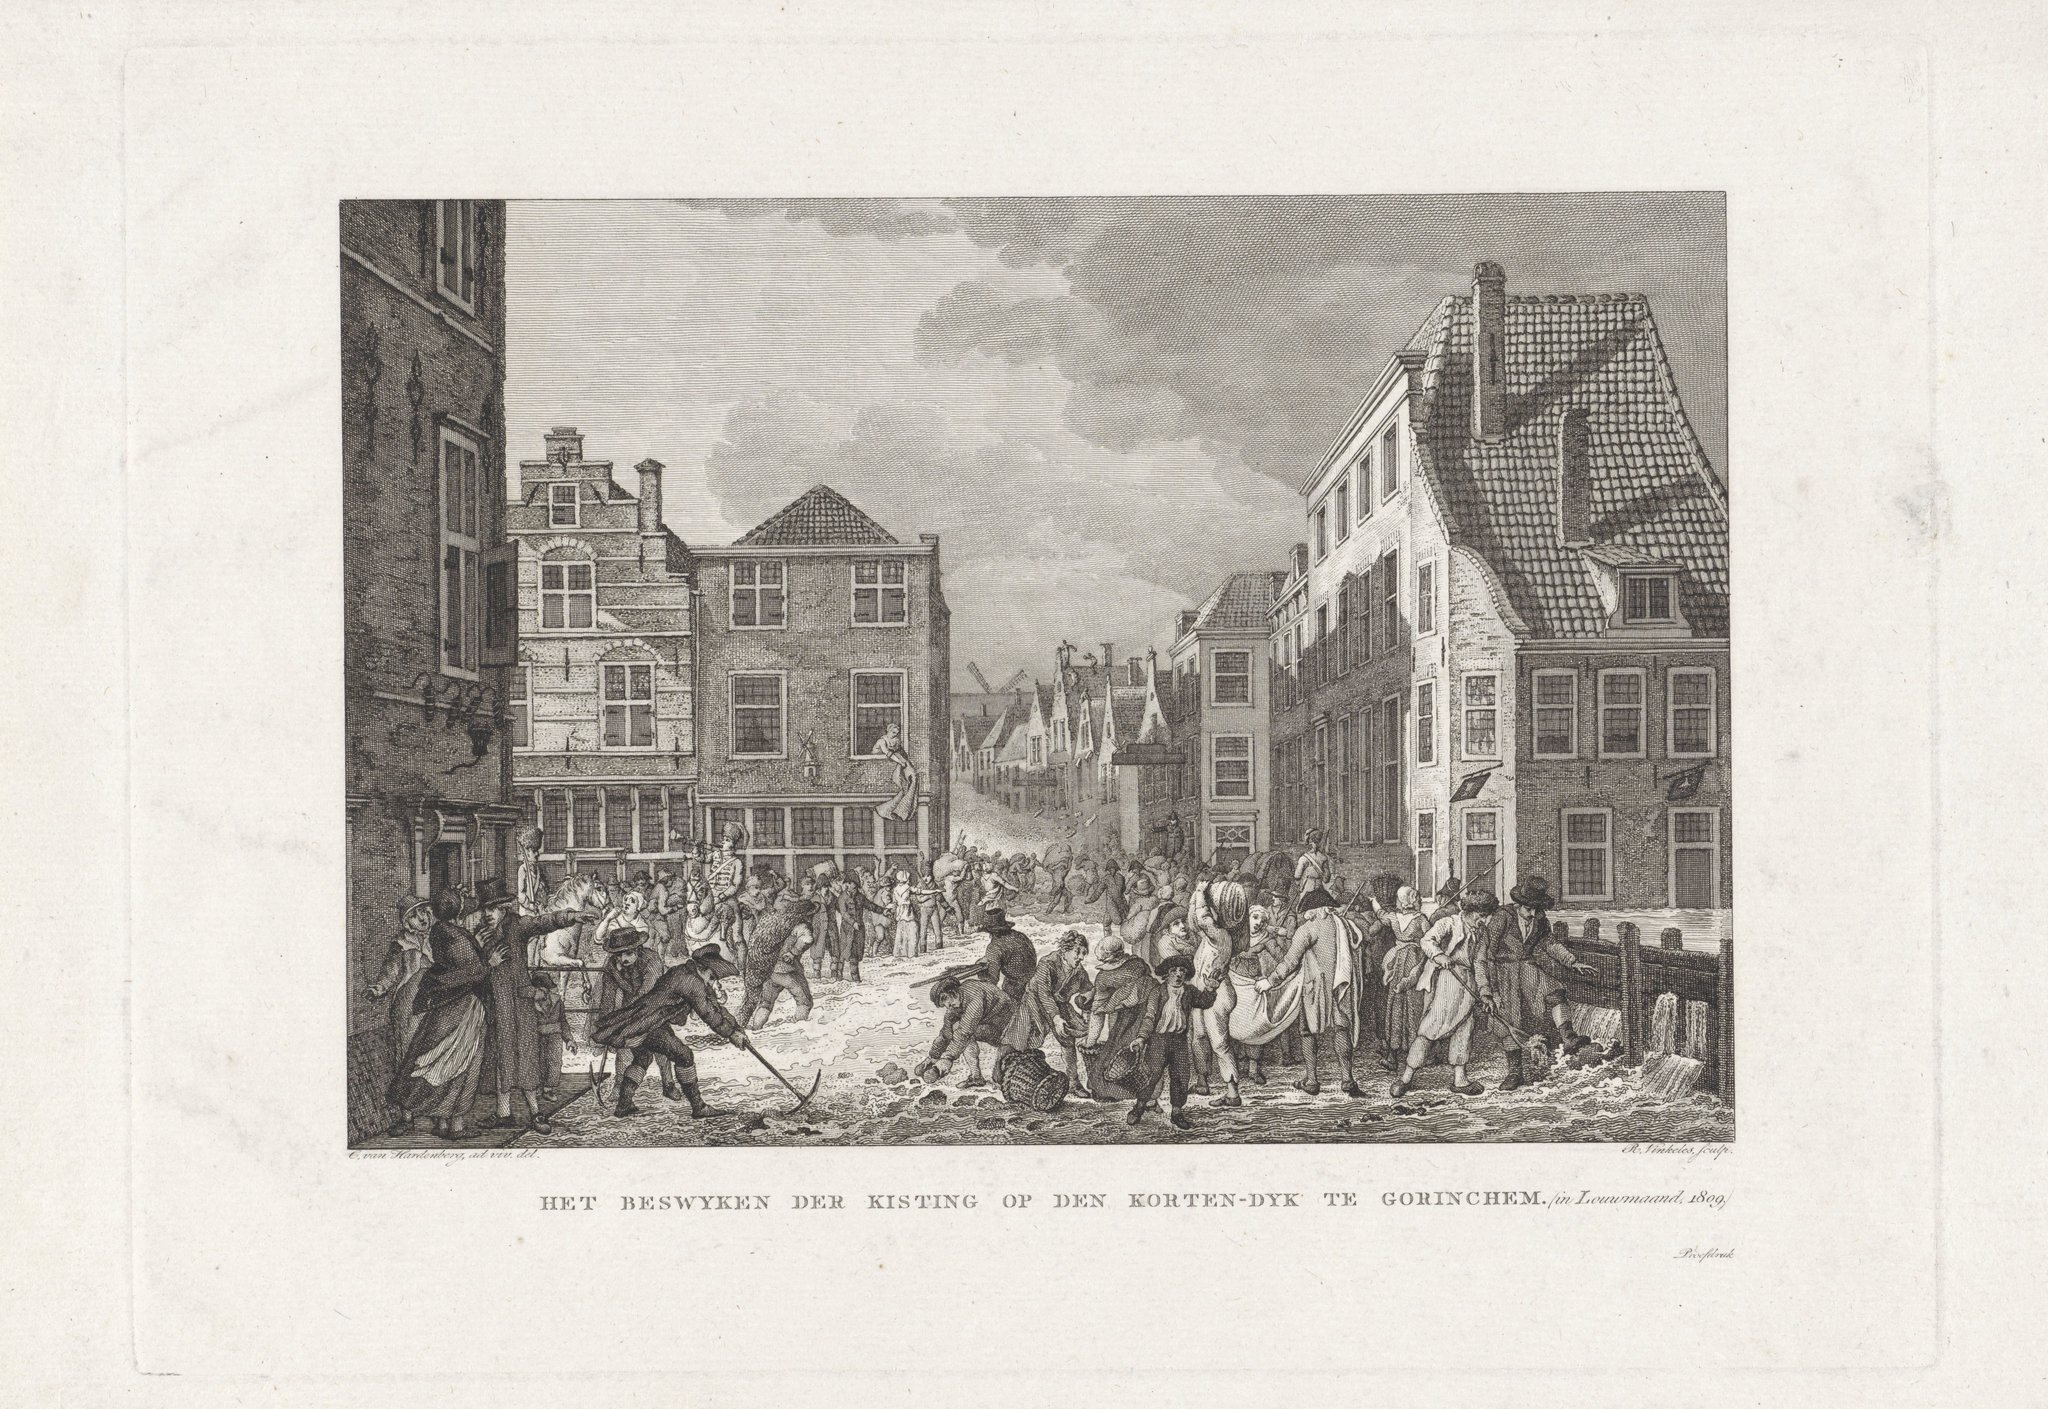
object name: print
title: Het beswyken der kisting op den Korten-Dyk te Gorinchem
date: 1809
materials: paper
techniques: engraving, etching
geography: amsterdam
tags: flood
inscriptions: collector's mark: Lugt 2228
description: Illustratie voor: Ewijk, Hendrik. Geschiedkundig verslag der dijkbreuken en overstroomingen in Holland, in 1809. Amsterdam: J. Allart en J. Ruys, 1809.